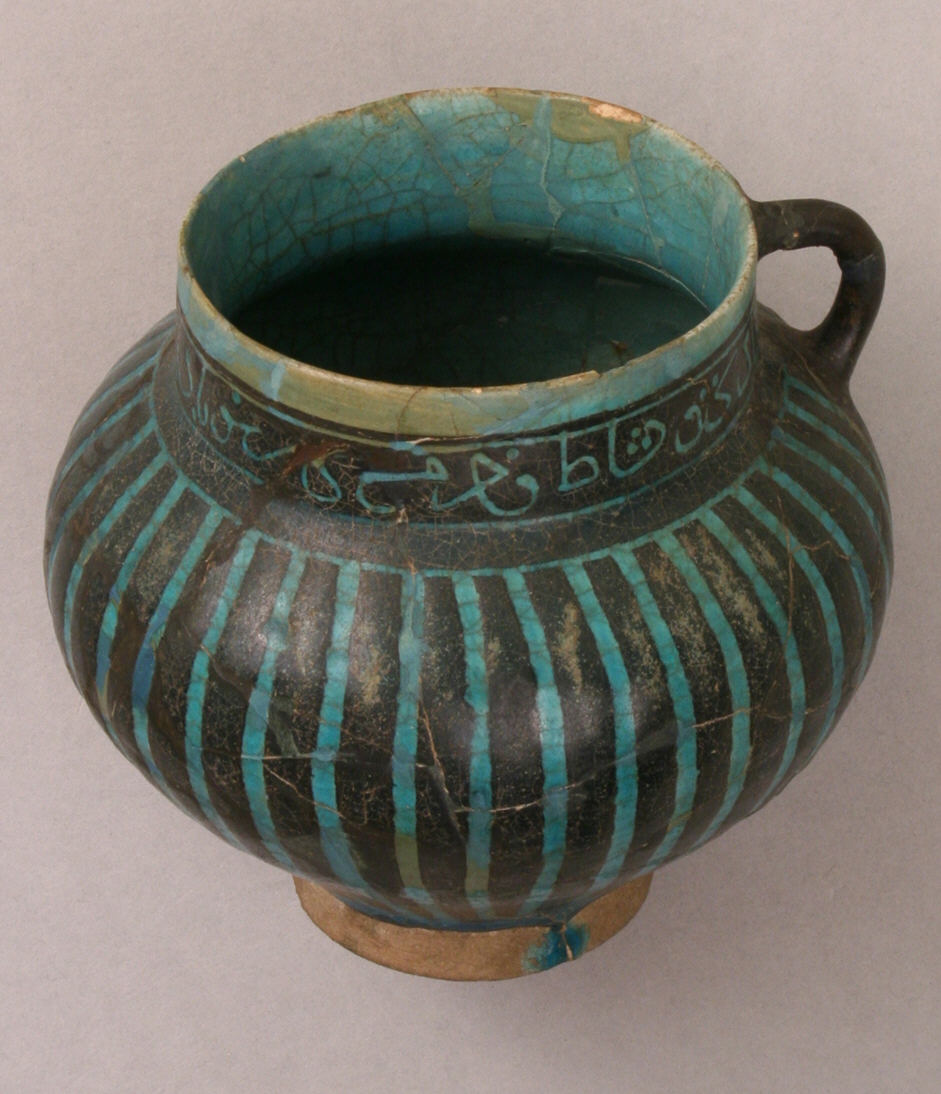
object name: ewer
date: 1201-1300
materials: stonepaste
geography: iran